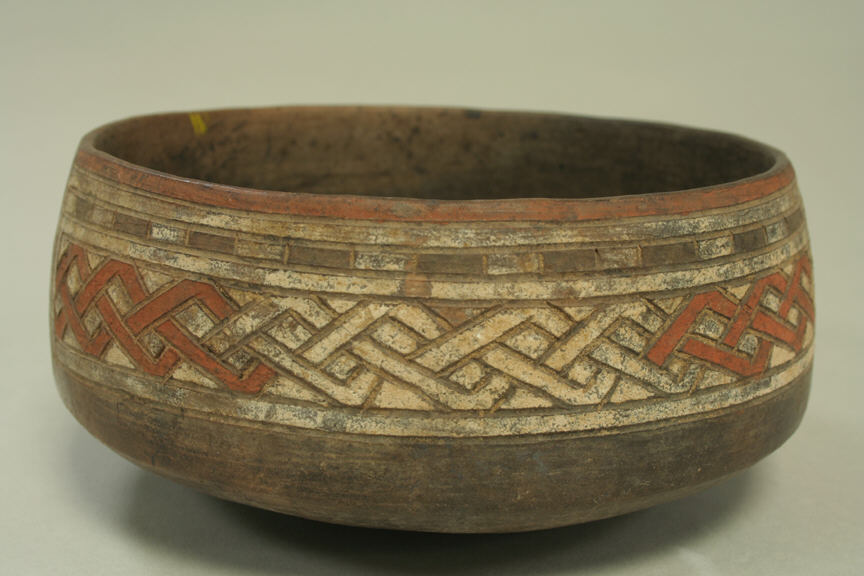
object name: bowl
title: Incised Painted Bowl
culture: paracas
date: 500-201 BCE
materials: ceramic, pigment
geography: peru